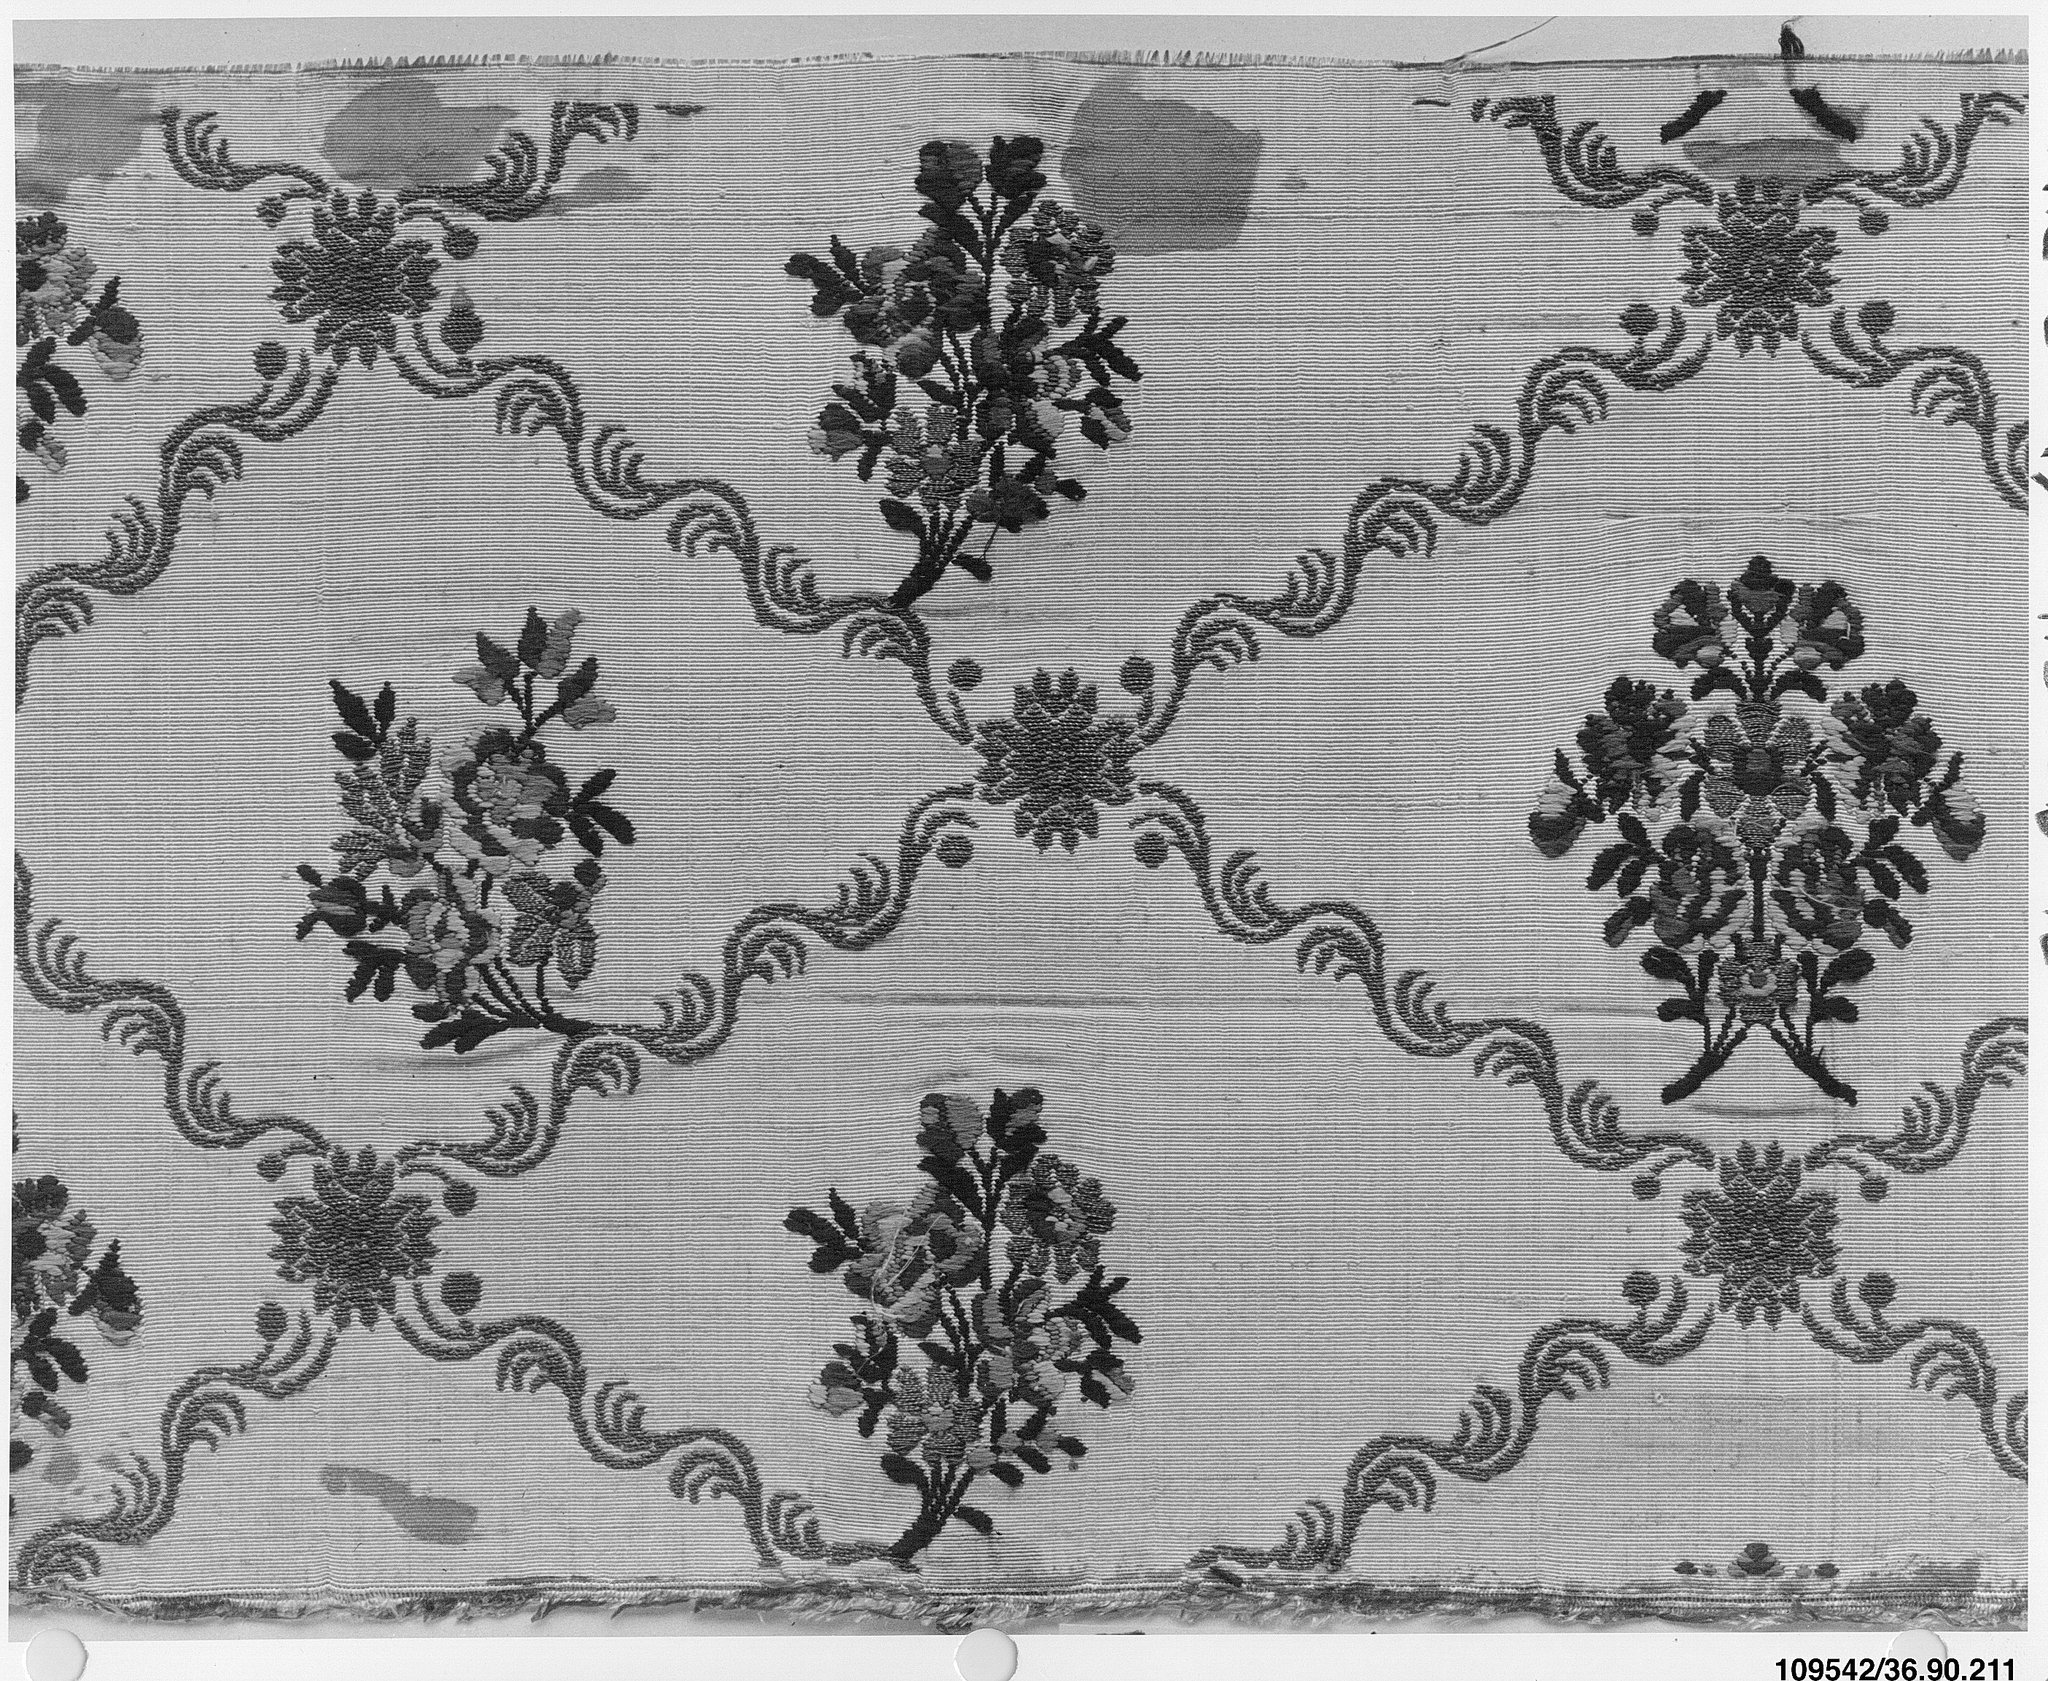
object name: piece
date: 1760-1770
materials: metal thread, silk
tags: flowers,leaves